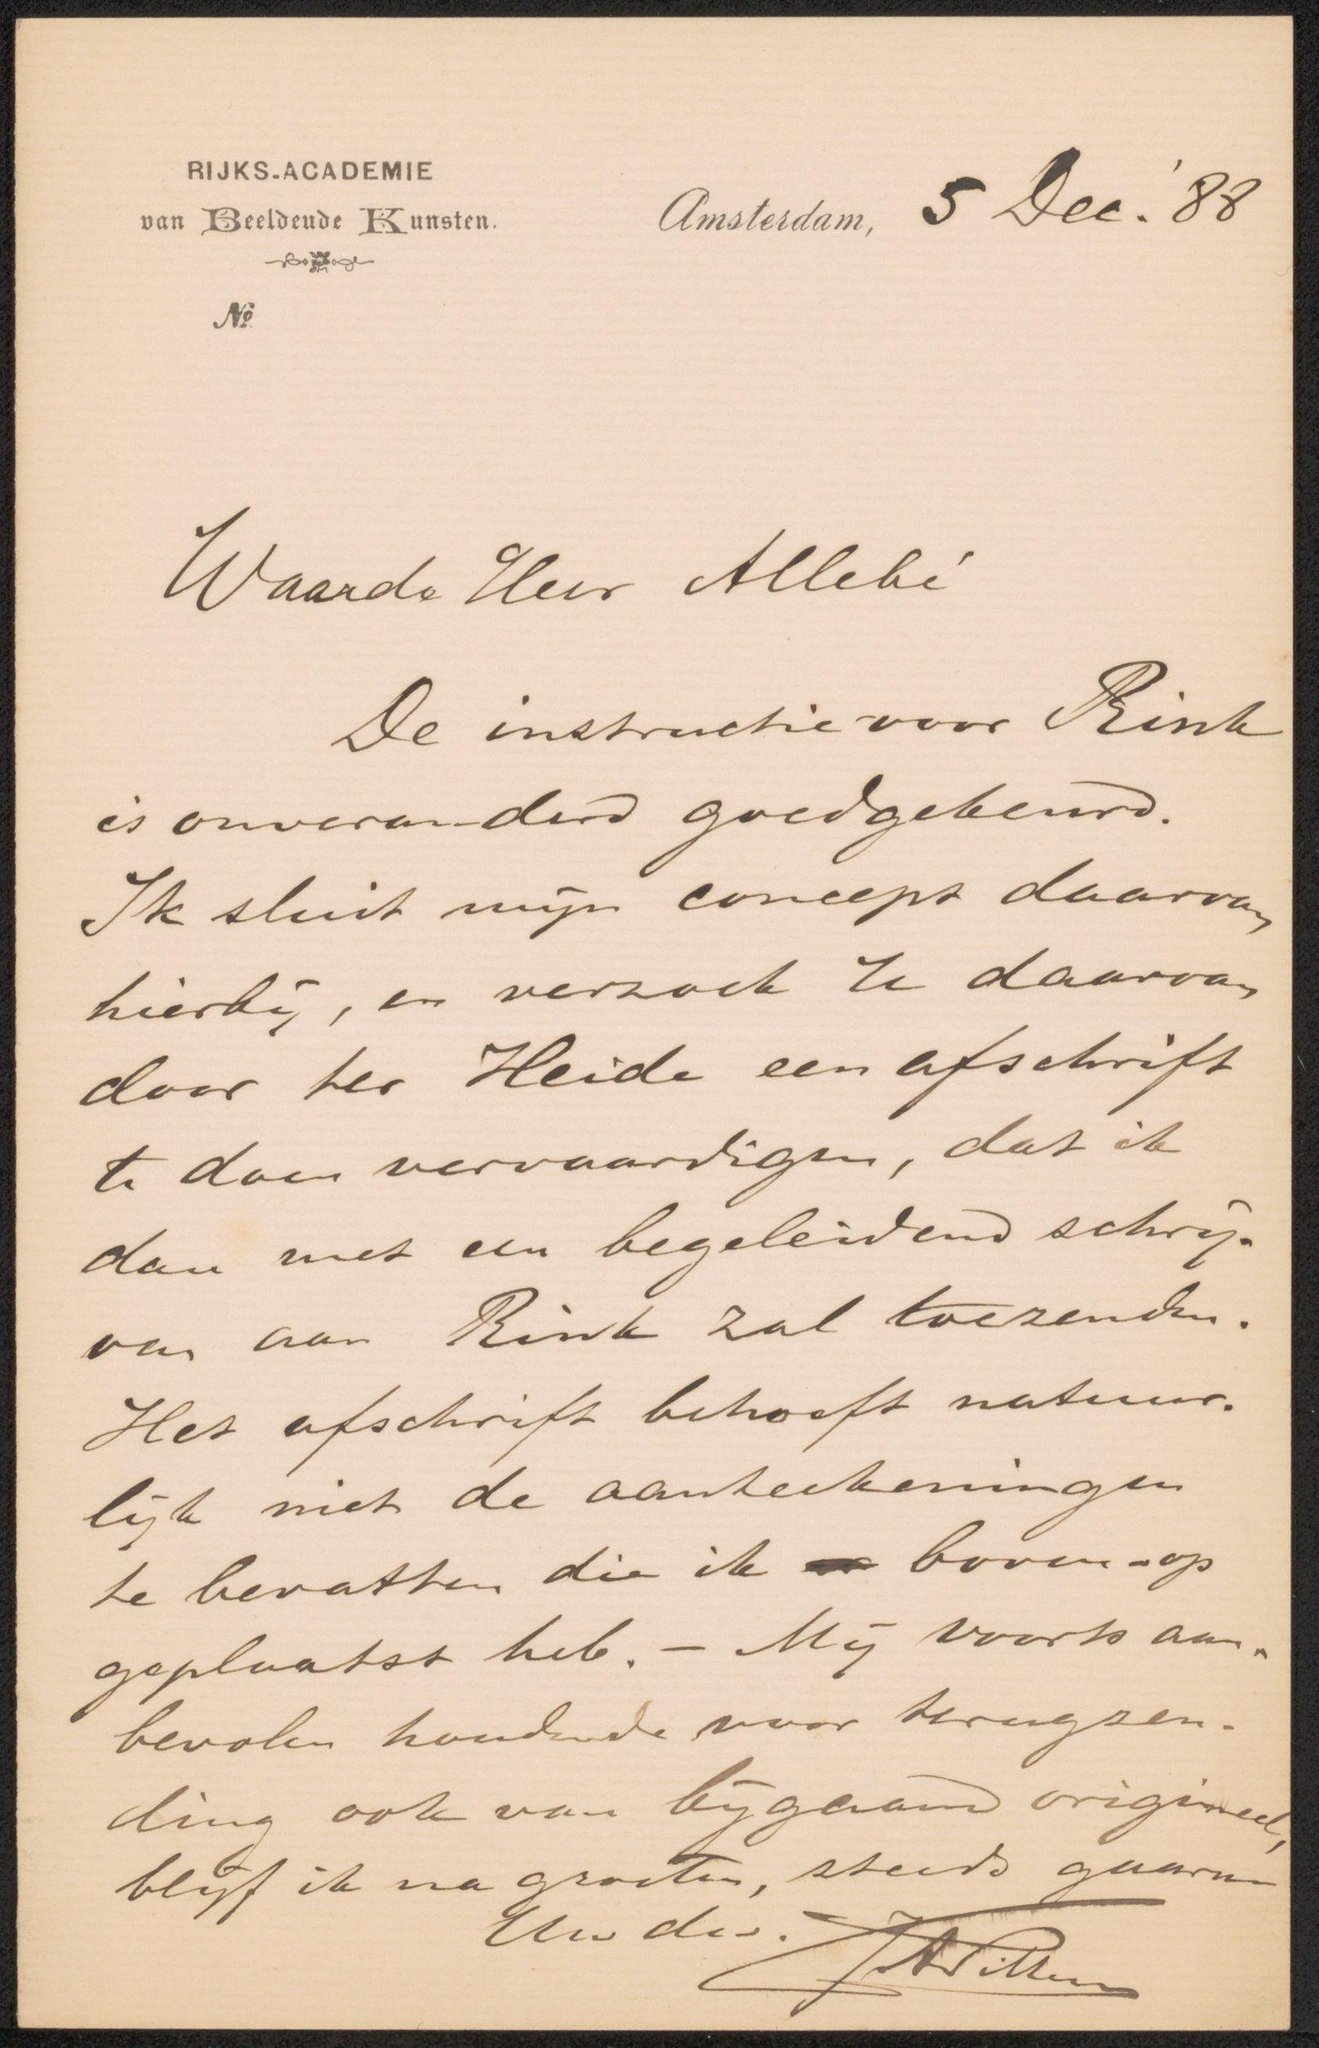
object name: letter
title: Brief aan August Allebé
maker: jérôme alexander sillem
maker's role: politician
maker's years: 1840-1912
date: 1888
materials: ink, paper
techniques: pen, printing, writing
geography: amsterdam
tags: official, j.g. ter heide, amsterdam, august allebé, veghel, print maker, draughtsman, paul rink, education, tuition of the artist (in general)